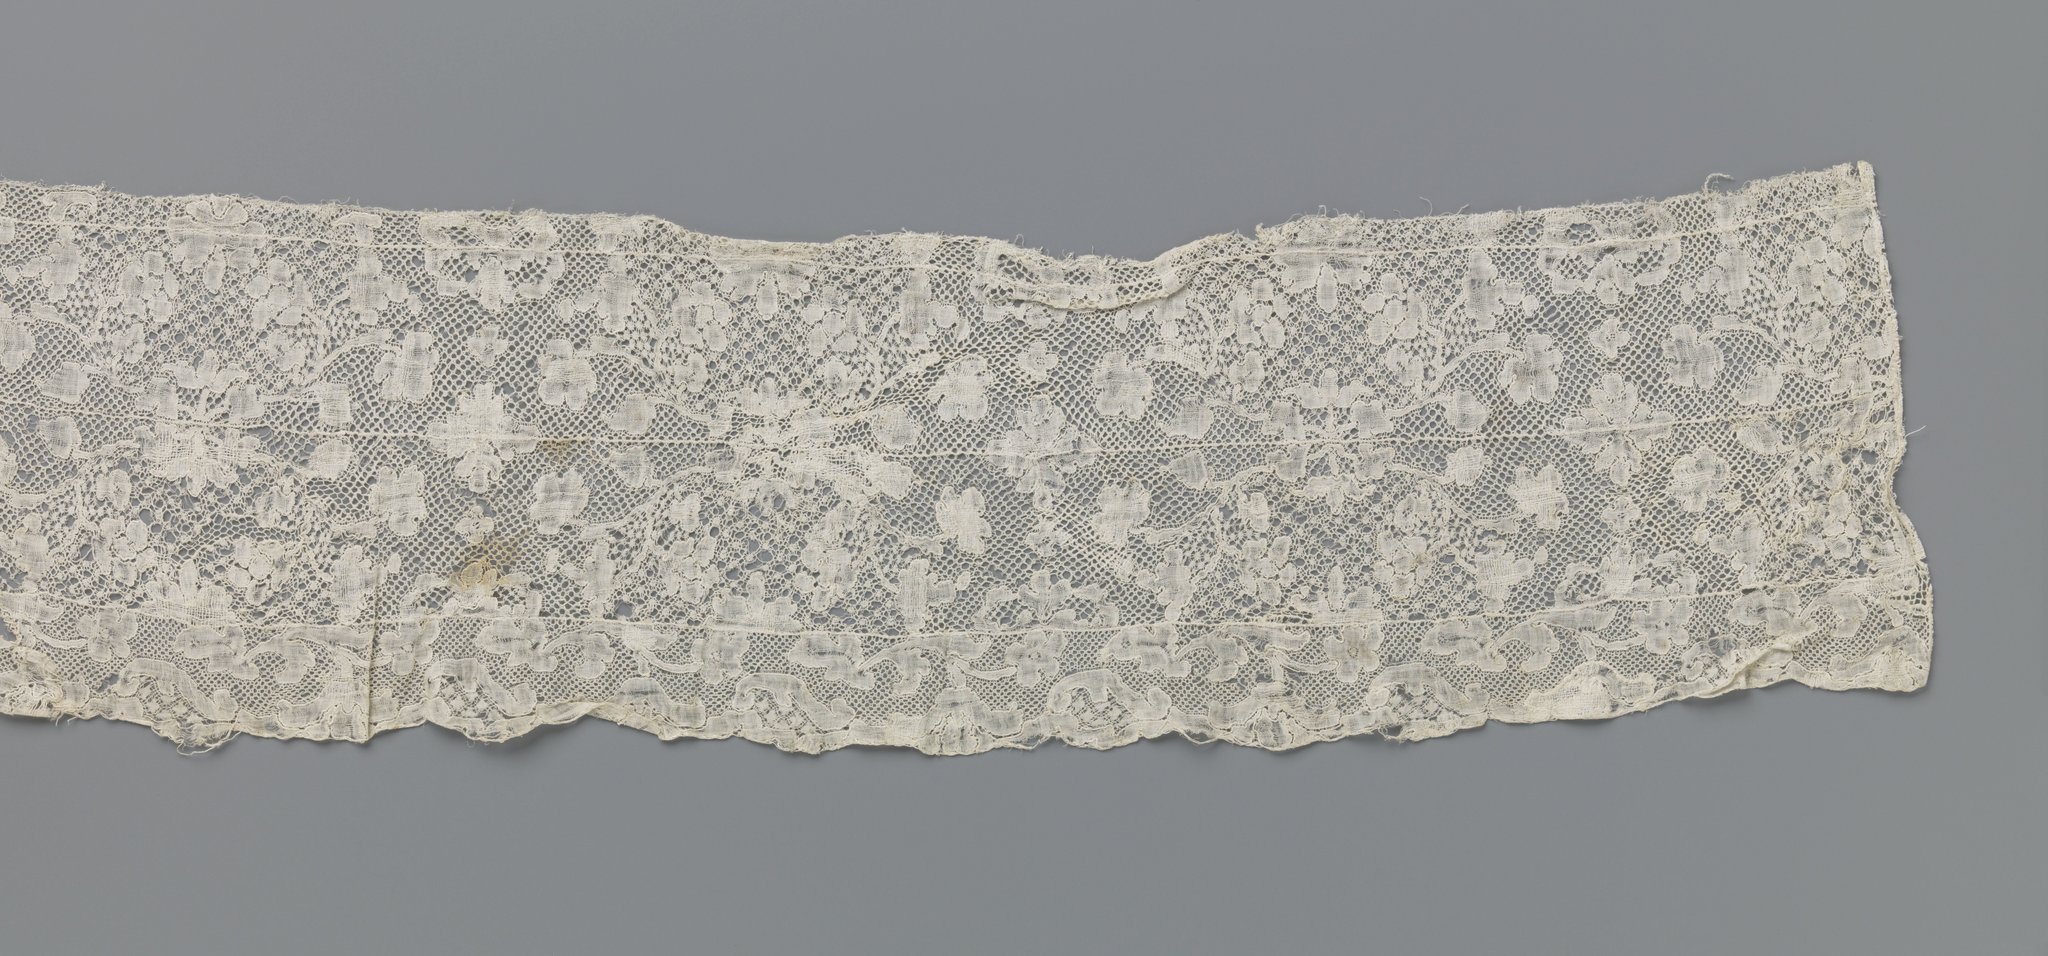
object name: cap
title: Strook kloskant voor een 'Duitse muts' gebruikt in de Friese dracht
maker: Anonymous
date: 1750-1780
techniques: lace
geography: friesland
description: Strook naturelkleurige kloskant, Antwerpse pottekant. De strook is samengesteld uit vier stroken en bedoeld voor een 'Duitse muts' gebruikt in de Friese dracht. De middelste twee stroken zijn gelijk en zijn symmetrisch tegen elkaar genaaid. Het patroon heeft in een krans geplaatste bloemen afgewisseld met gehalveerde viervoudige bloemen, door de naad weer tot een geheel geworden. De onderste strook heeft een lopend patroon van een rocaille en een dubbele bloemtak waarbij de rocaille en één van de bloemen tevens de flauwe schulpenrand vormen. De bovenste strook is een afgeknipt deel van de middelste soort en is afgewerkt met een zeer smal, deels ontbrekend zoompje. De motieven zijn met elkaar verbonden door een maasgrond. De motieven zijn gemaakt in linnenslag en er zijn twee soorten siergrond gebruikt, om de motieven lopen dikkere contourdraden.